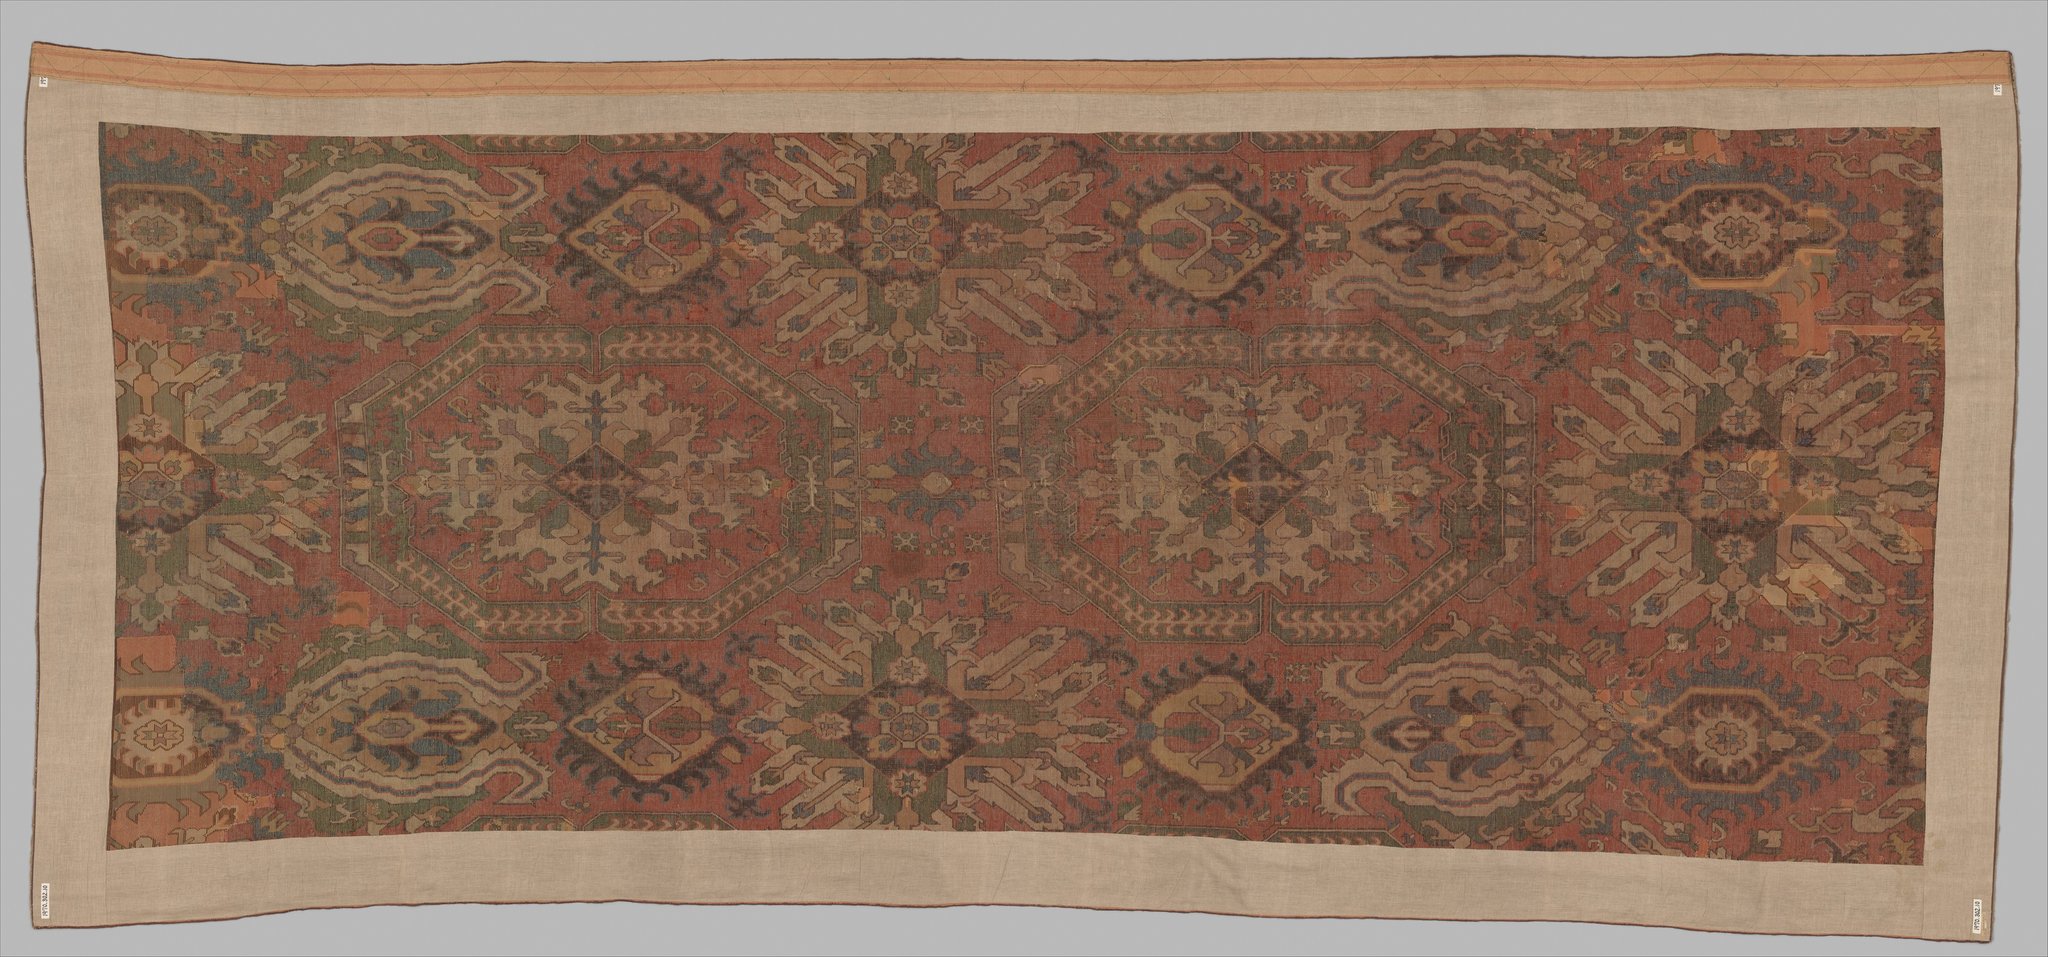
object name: carpet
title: Carpet with Geometricized Floral Design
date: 1767-1800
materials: wool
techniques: pile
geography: caucasus